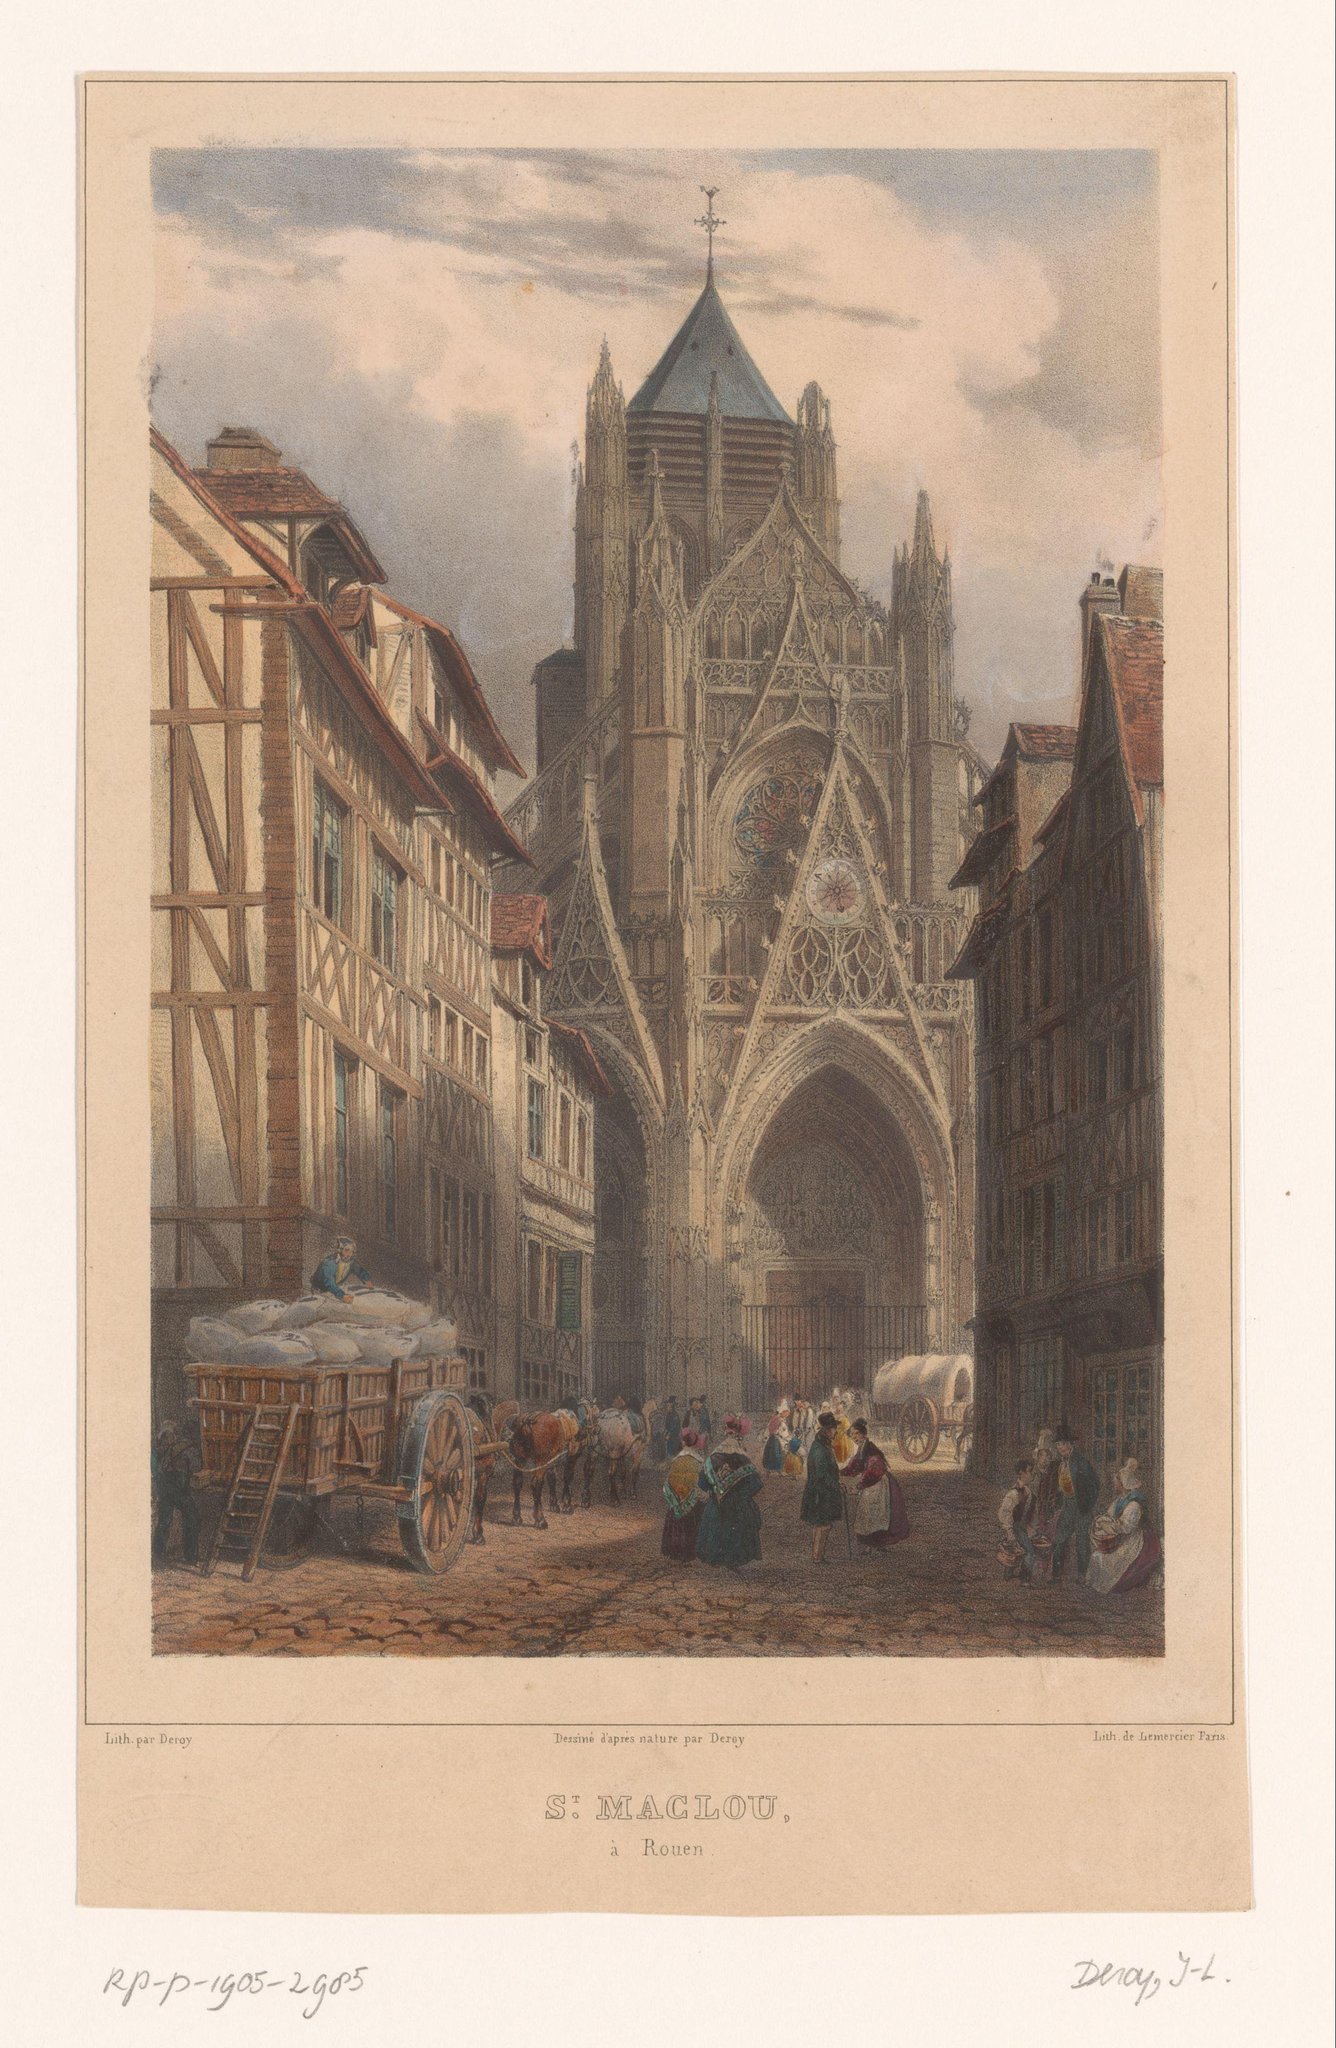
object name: print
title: Gezichten in Frankrijk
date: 1834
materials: paper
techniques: hand coloring, lithograph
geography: paris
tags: church (exterior)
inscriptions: check stamp: Lugt 1397c